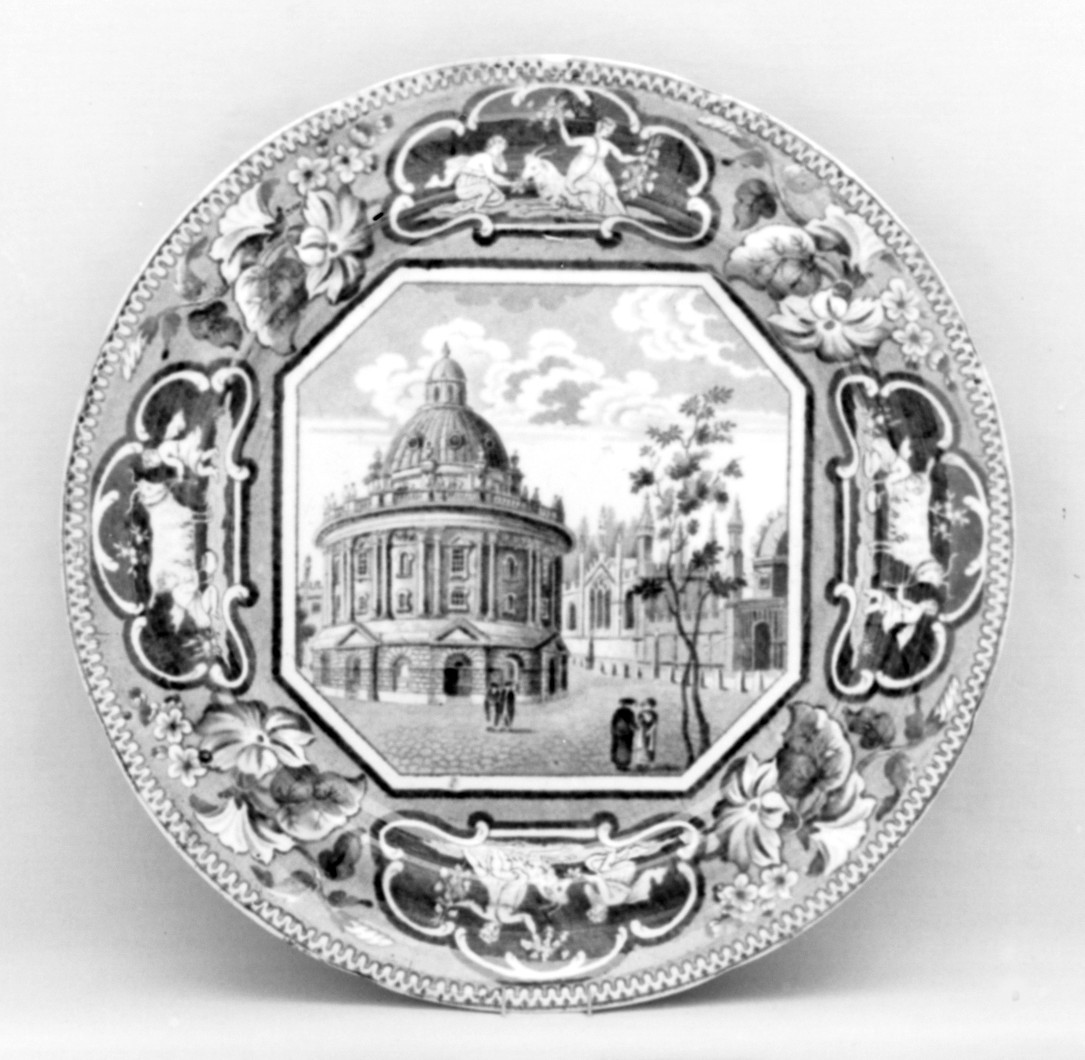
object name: plate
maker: j. and w. ridgway, cauldon, stoke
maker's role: factory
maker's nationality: british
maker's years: 1809-1830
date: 1801-1900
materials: pottery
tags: buildings,goats